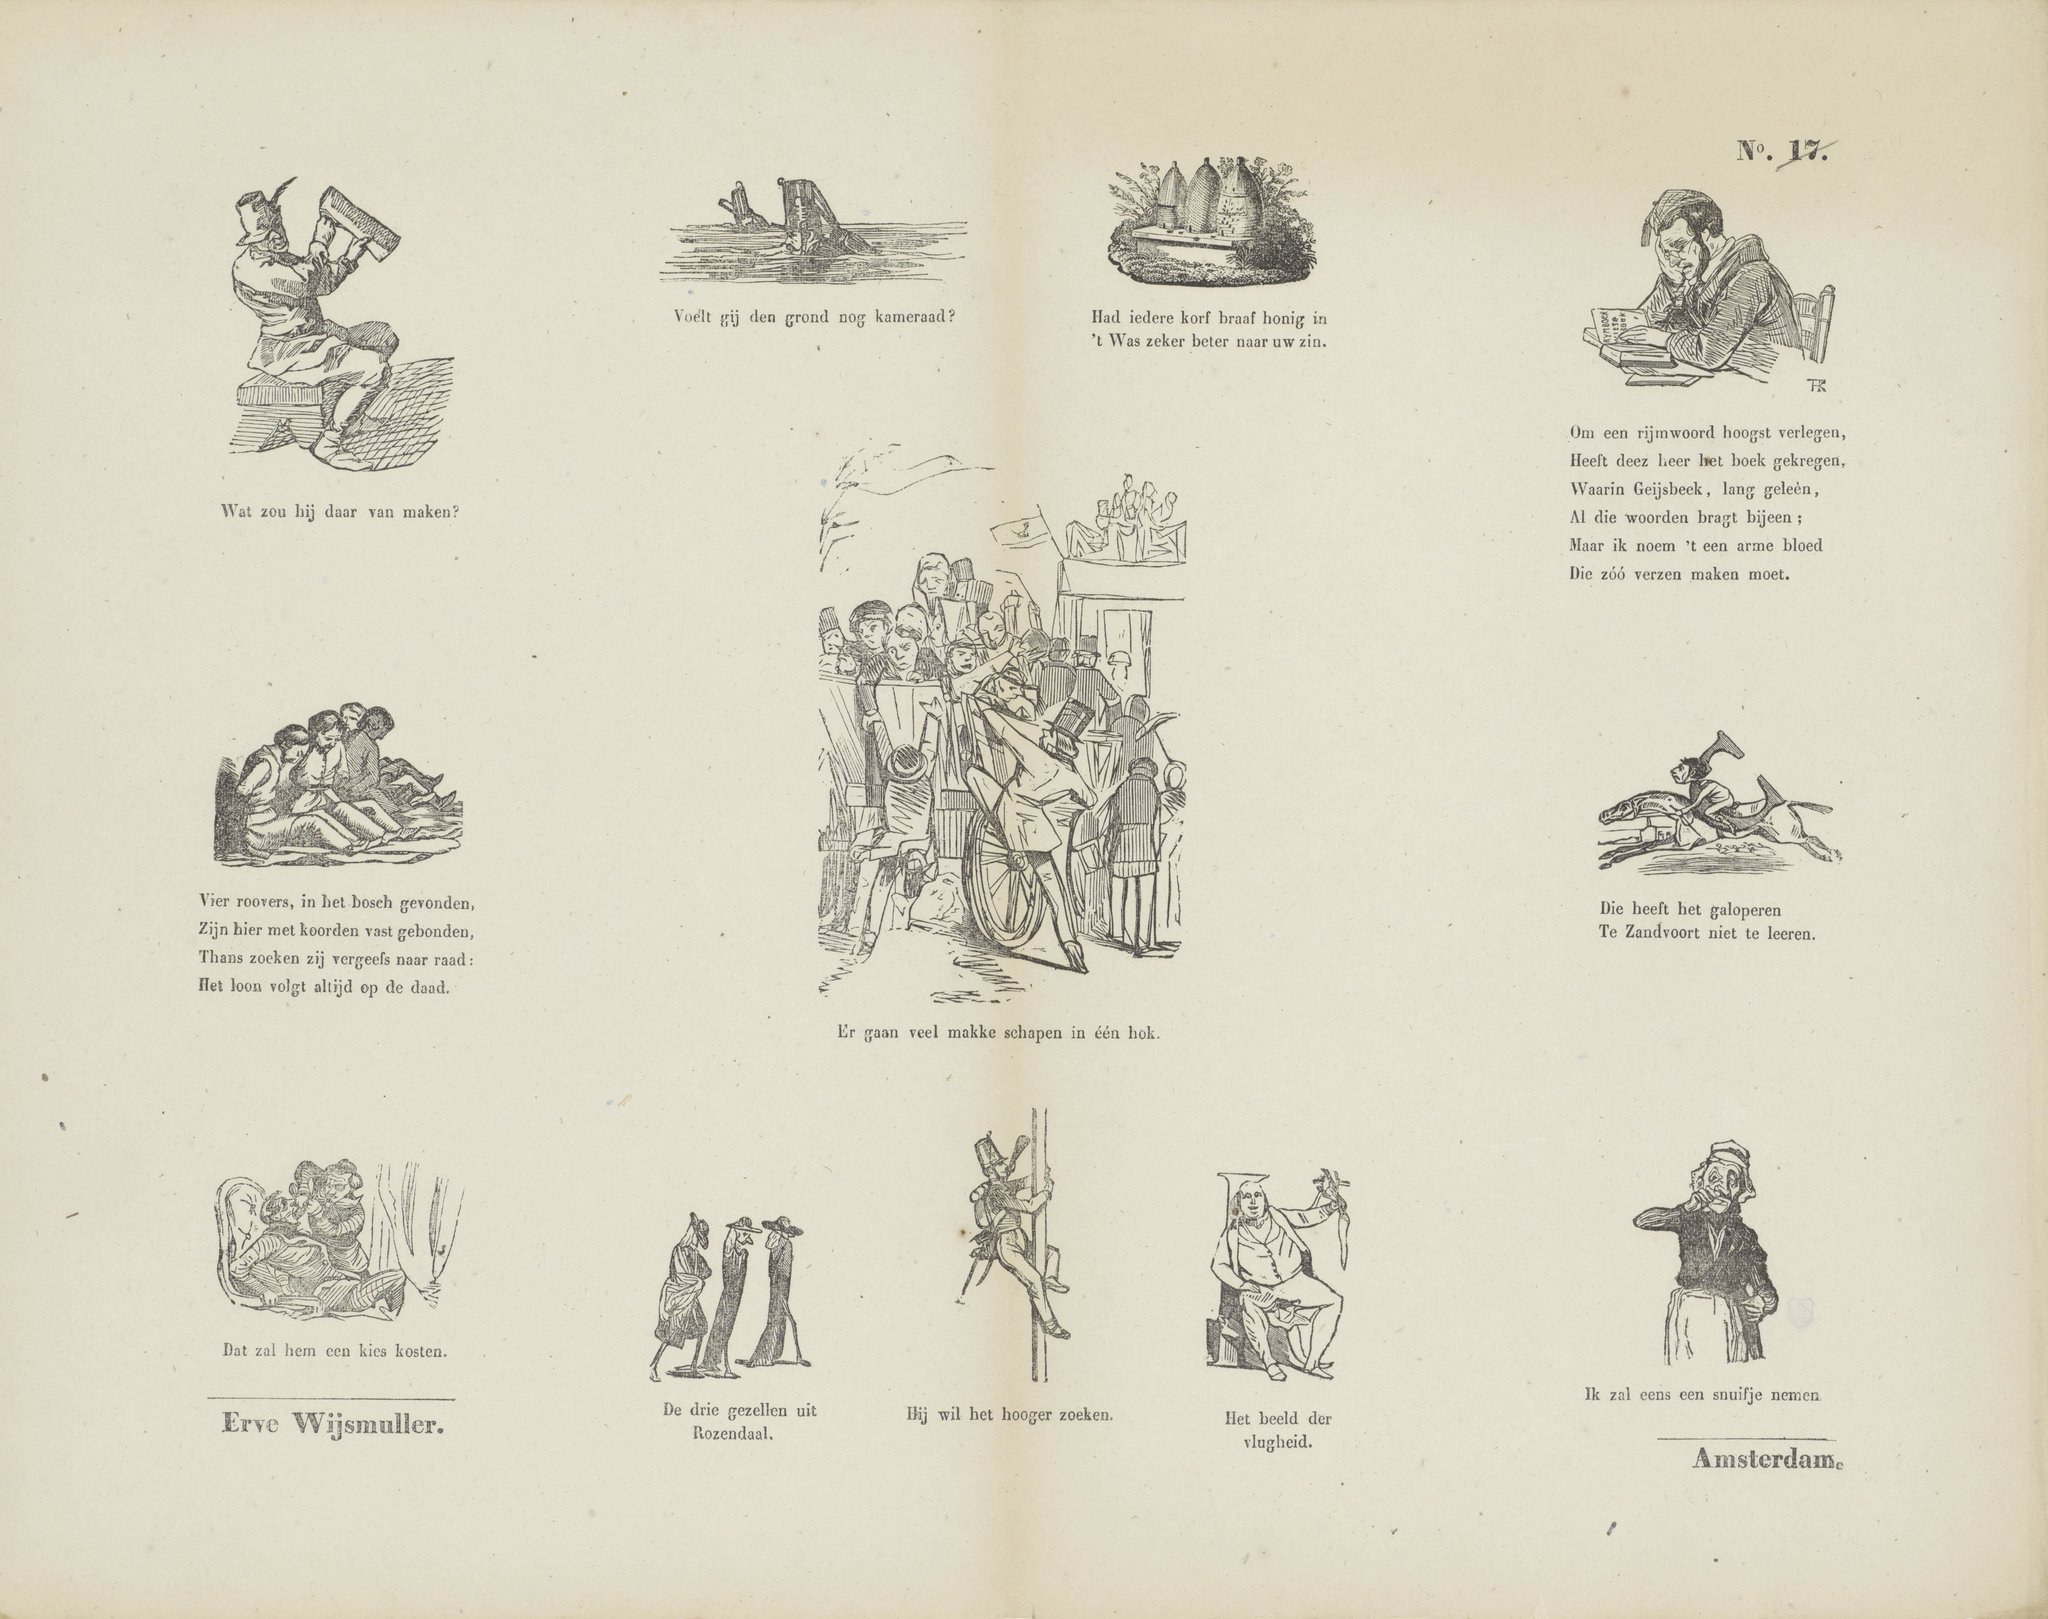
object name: print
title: Verschillende voorstellingen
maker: Anonymous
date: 1828-1913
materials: paper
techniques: letterpress printing, line block, engraving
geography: amsterdam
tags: reading, characters (human types), bee-hive, the soldier; the soldier's life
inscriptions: collector's mark: Lugt 2760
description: Blad met 12 voorstellingen van verschillende aard, waaronder een zwemmende soldaten, bijenkorven, een lezende man en vier vastgebonden rovers. Onder elke afbeelding een onderschrift. Onder de eerste afbeelding het onderschrift: Wat zou hij daar van maken? Genummerd rechtsboven: No. 17 (doorgestreept en verbeterd in 28, in potlood).